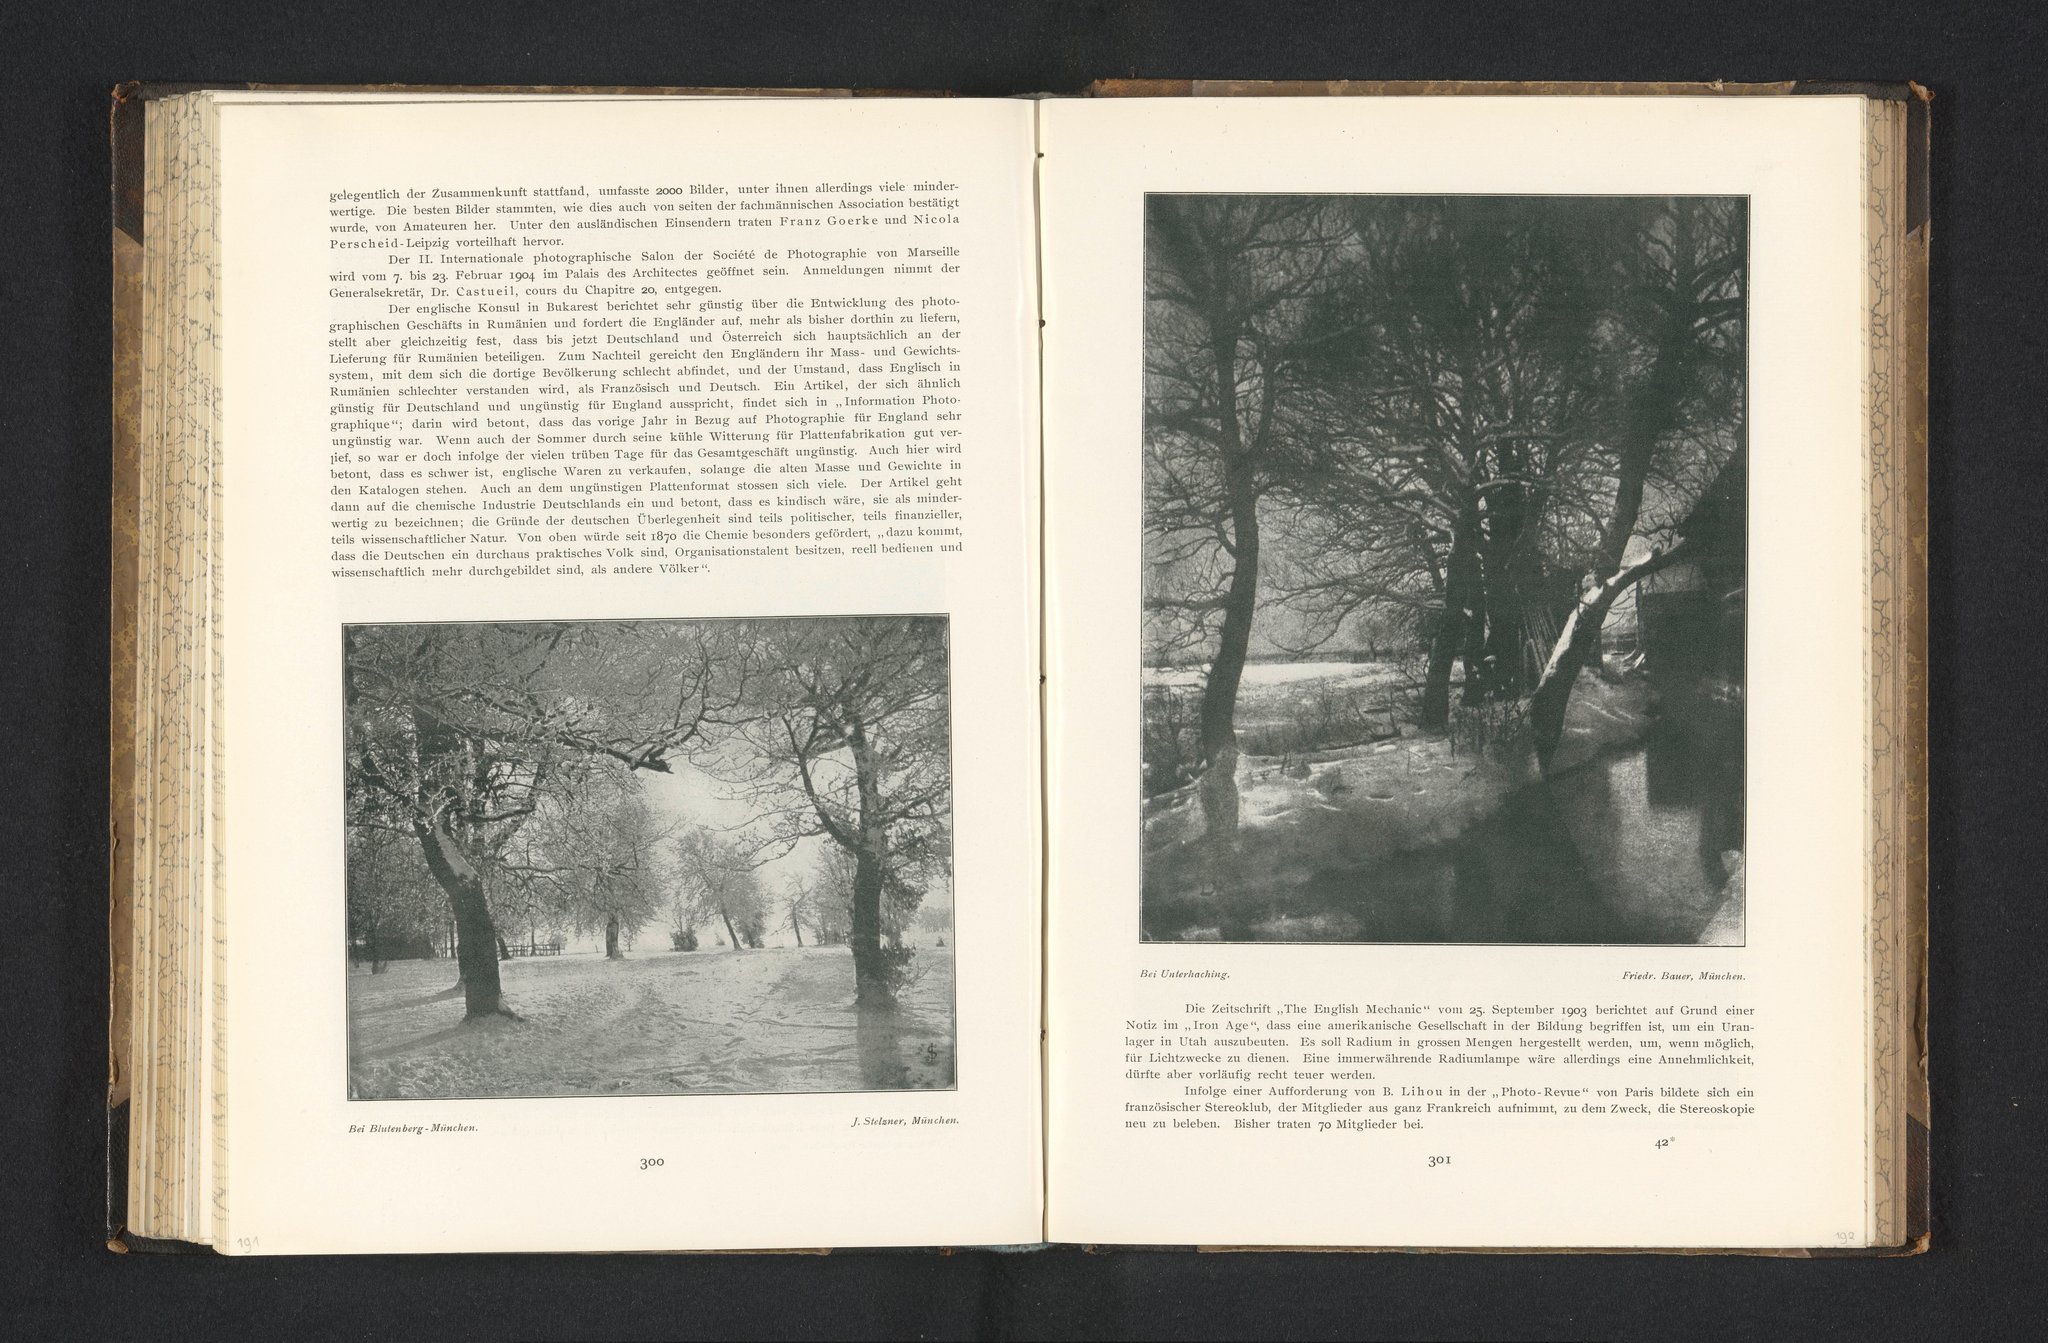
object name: page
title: Gezicht op bomen langs een sloot in de sneeuw bij München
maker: friedrich bauer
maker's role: fotograaf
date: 1898-1903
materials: paper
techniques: autotype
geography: berlin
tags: trees, snow, small canal, ditch